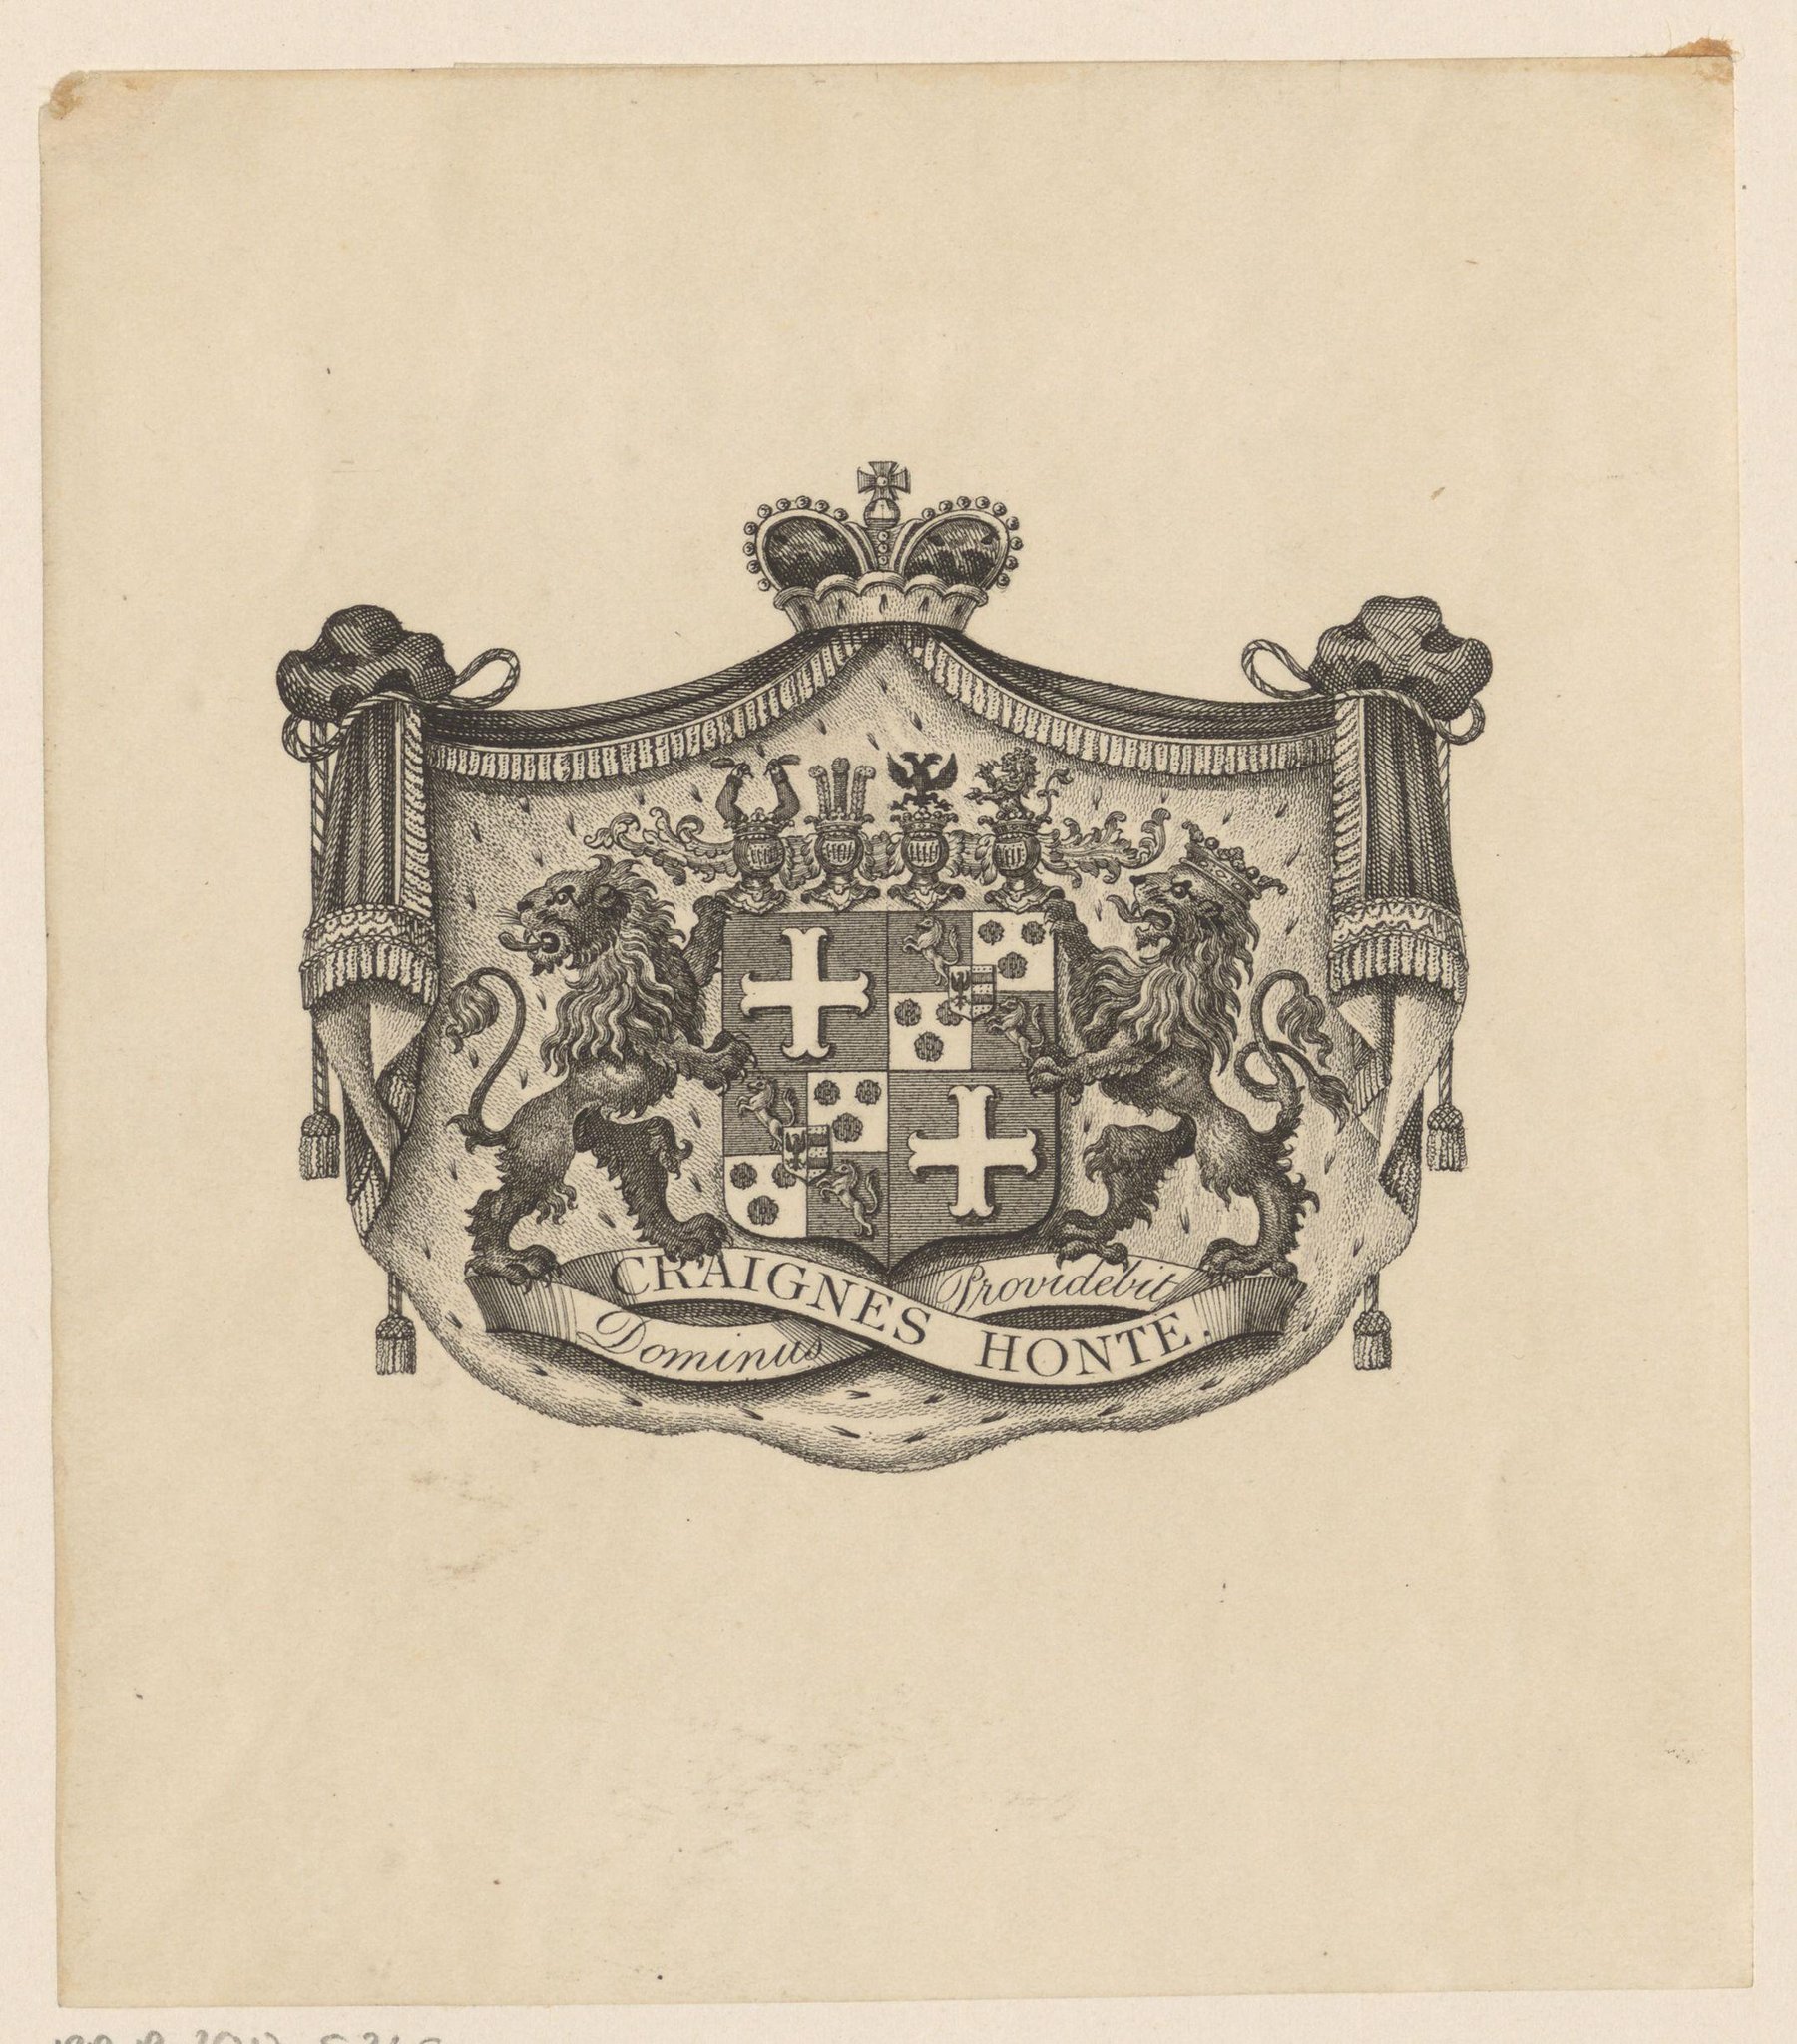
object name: bookplate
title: Dominus providebit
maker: Anonymous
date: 1800-1899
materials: paper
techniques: engraving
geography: england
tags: beasts of prey, predatory animals: lion, armorial bearing, heraldry